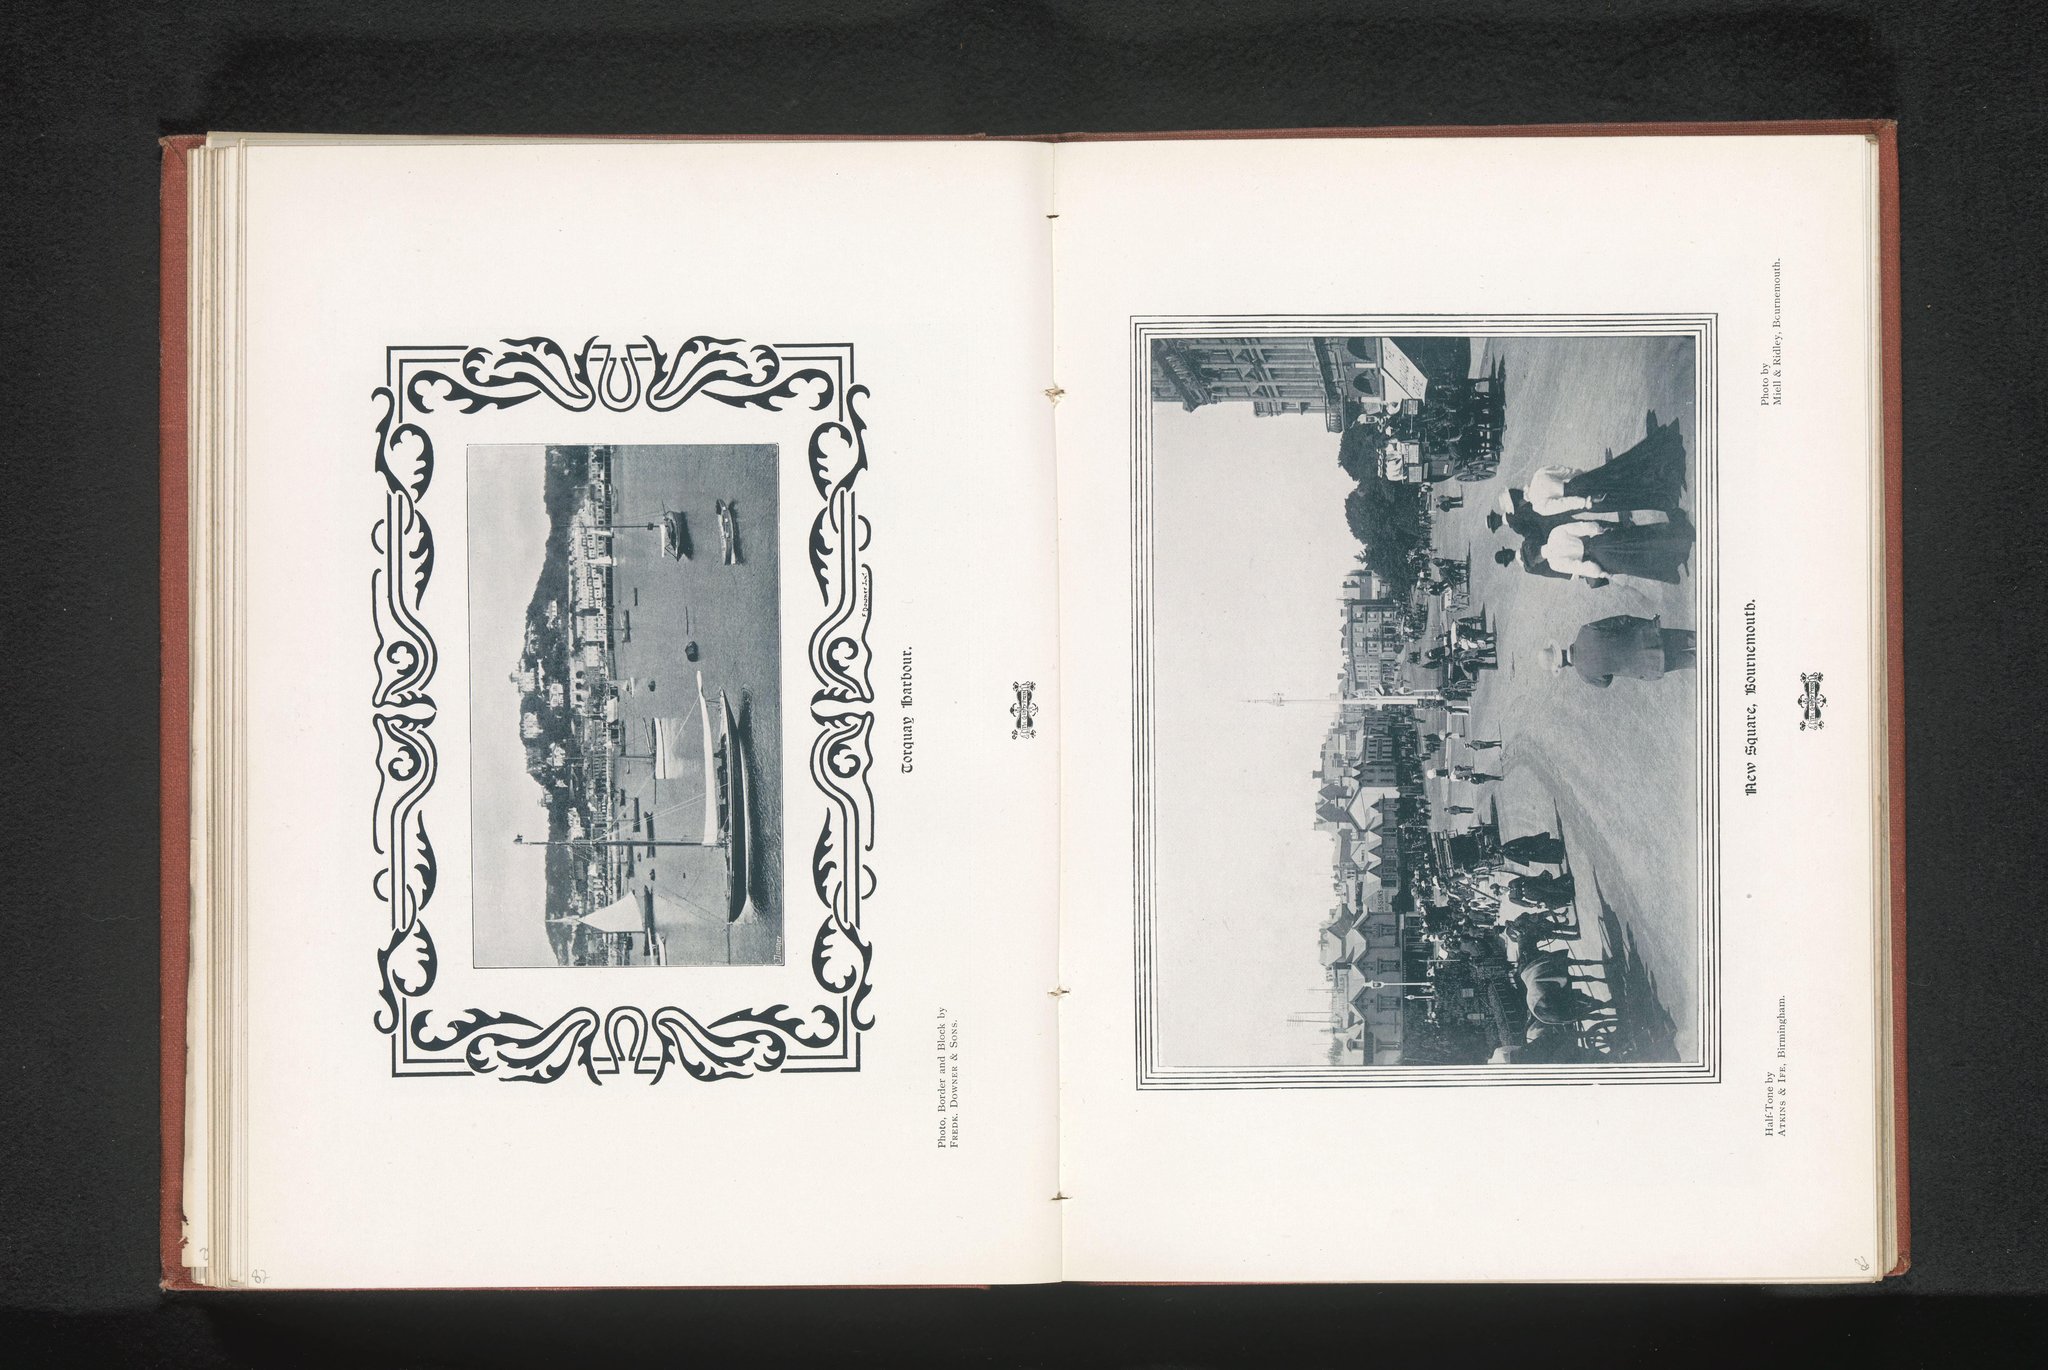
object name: photomechanical print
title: Torquay harbour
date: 1895-1900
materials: paper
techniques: autotype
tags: harbour, city-view in general; 'veduta'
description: Prent op zesde ongenummerde pagina na pagina 68.